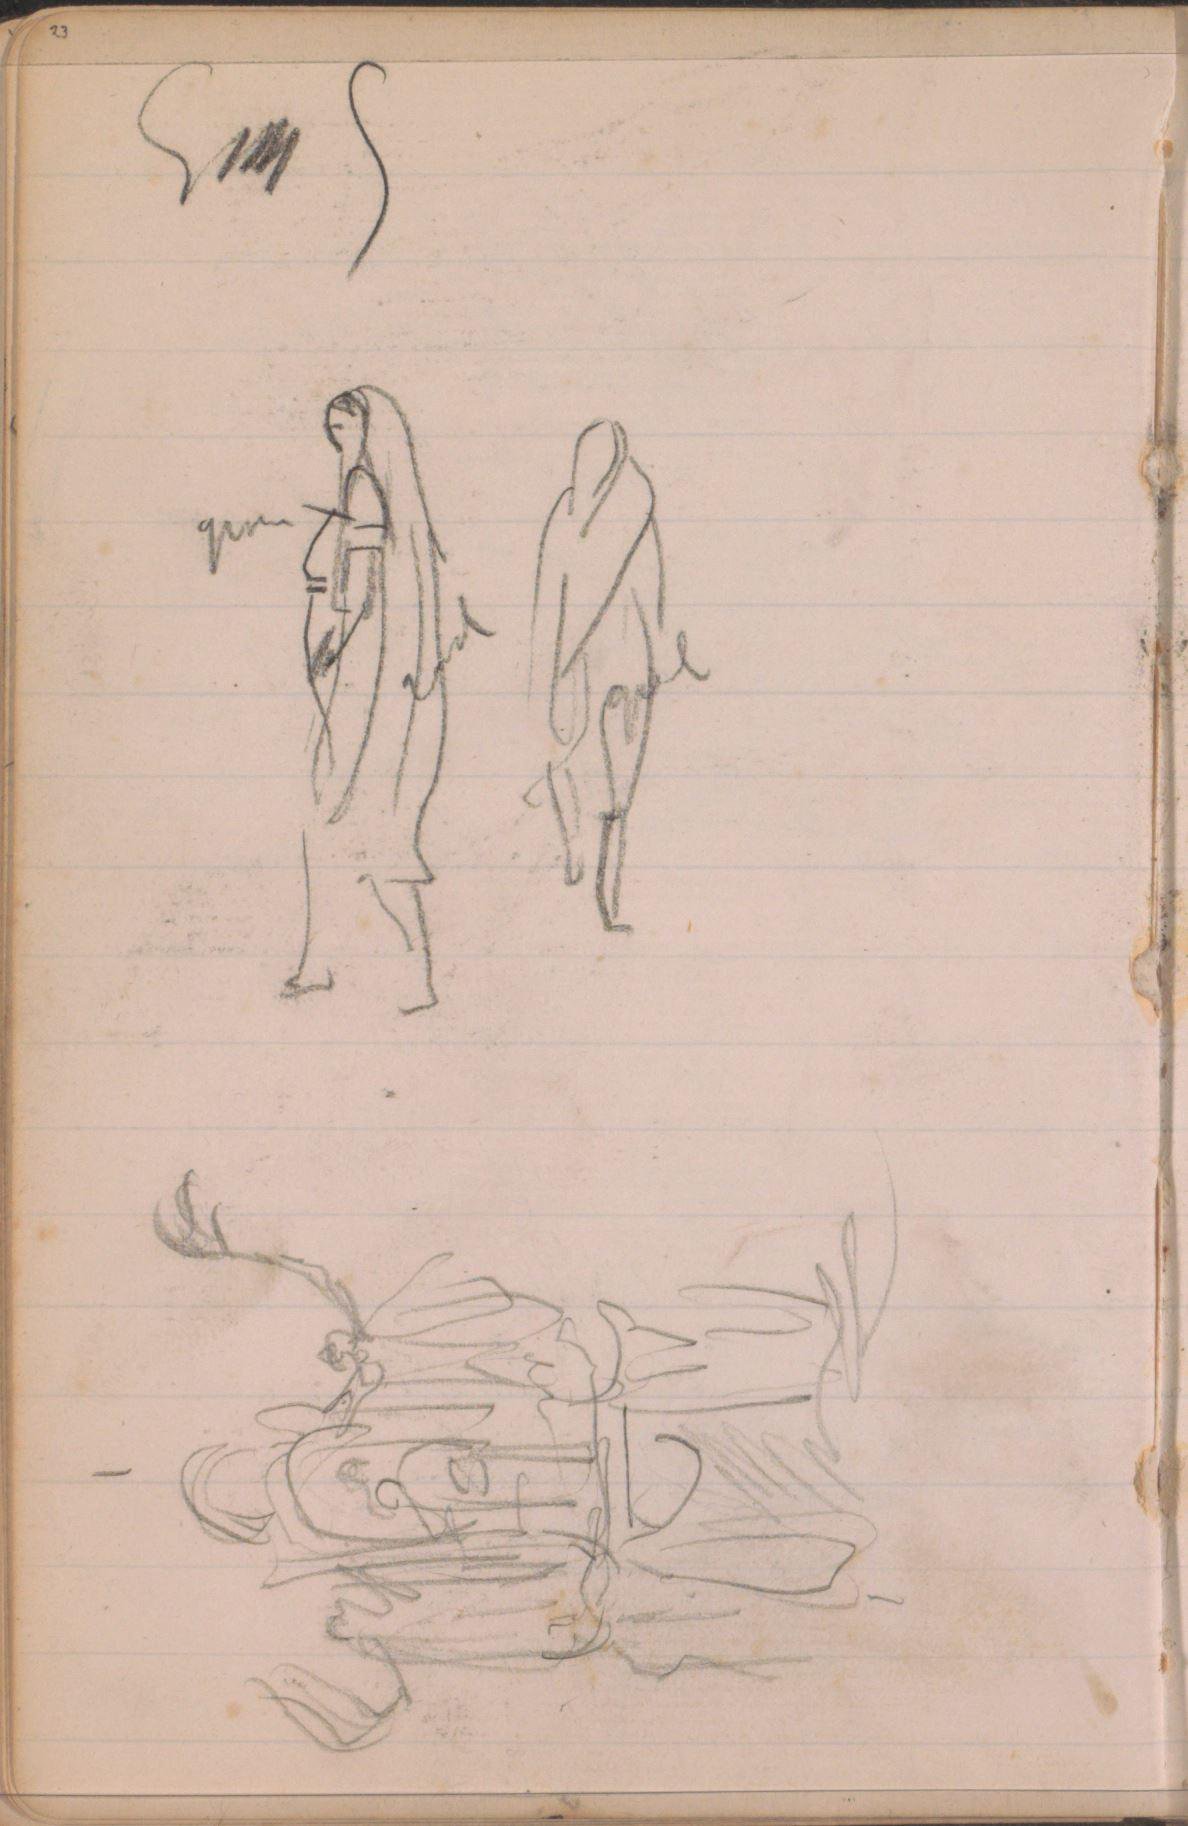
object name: sketchbook leaf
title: Vrouw in een sari, van opzij en van voren gezien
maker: marius bauer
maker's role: draughtsman, print maker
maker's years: 1867-1932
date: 1897-1898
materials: pencil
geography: india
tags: adult woman, folk costume, regional costume, asiatic races and peoples: indians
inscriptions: kleurnotitie, handgeschreven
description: Tevens een studie, mogelijk van figuren op een olifant. Pagina 23 uit een schetsboek met 84 bladen.